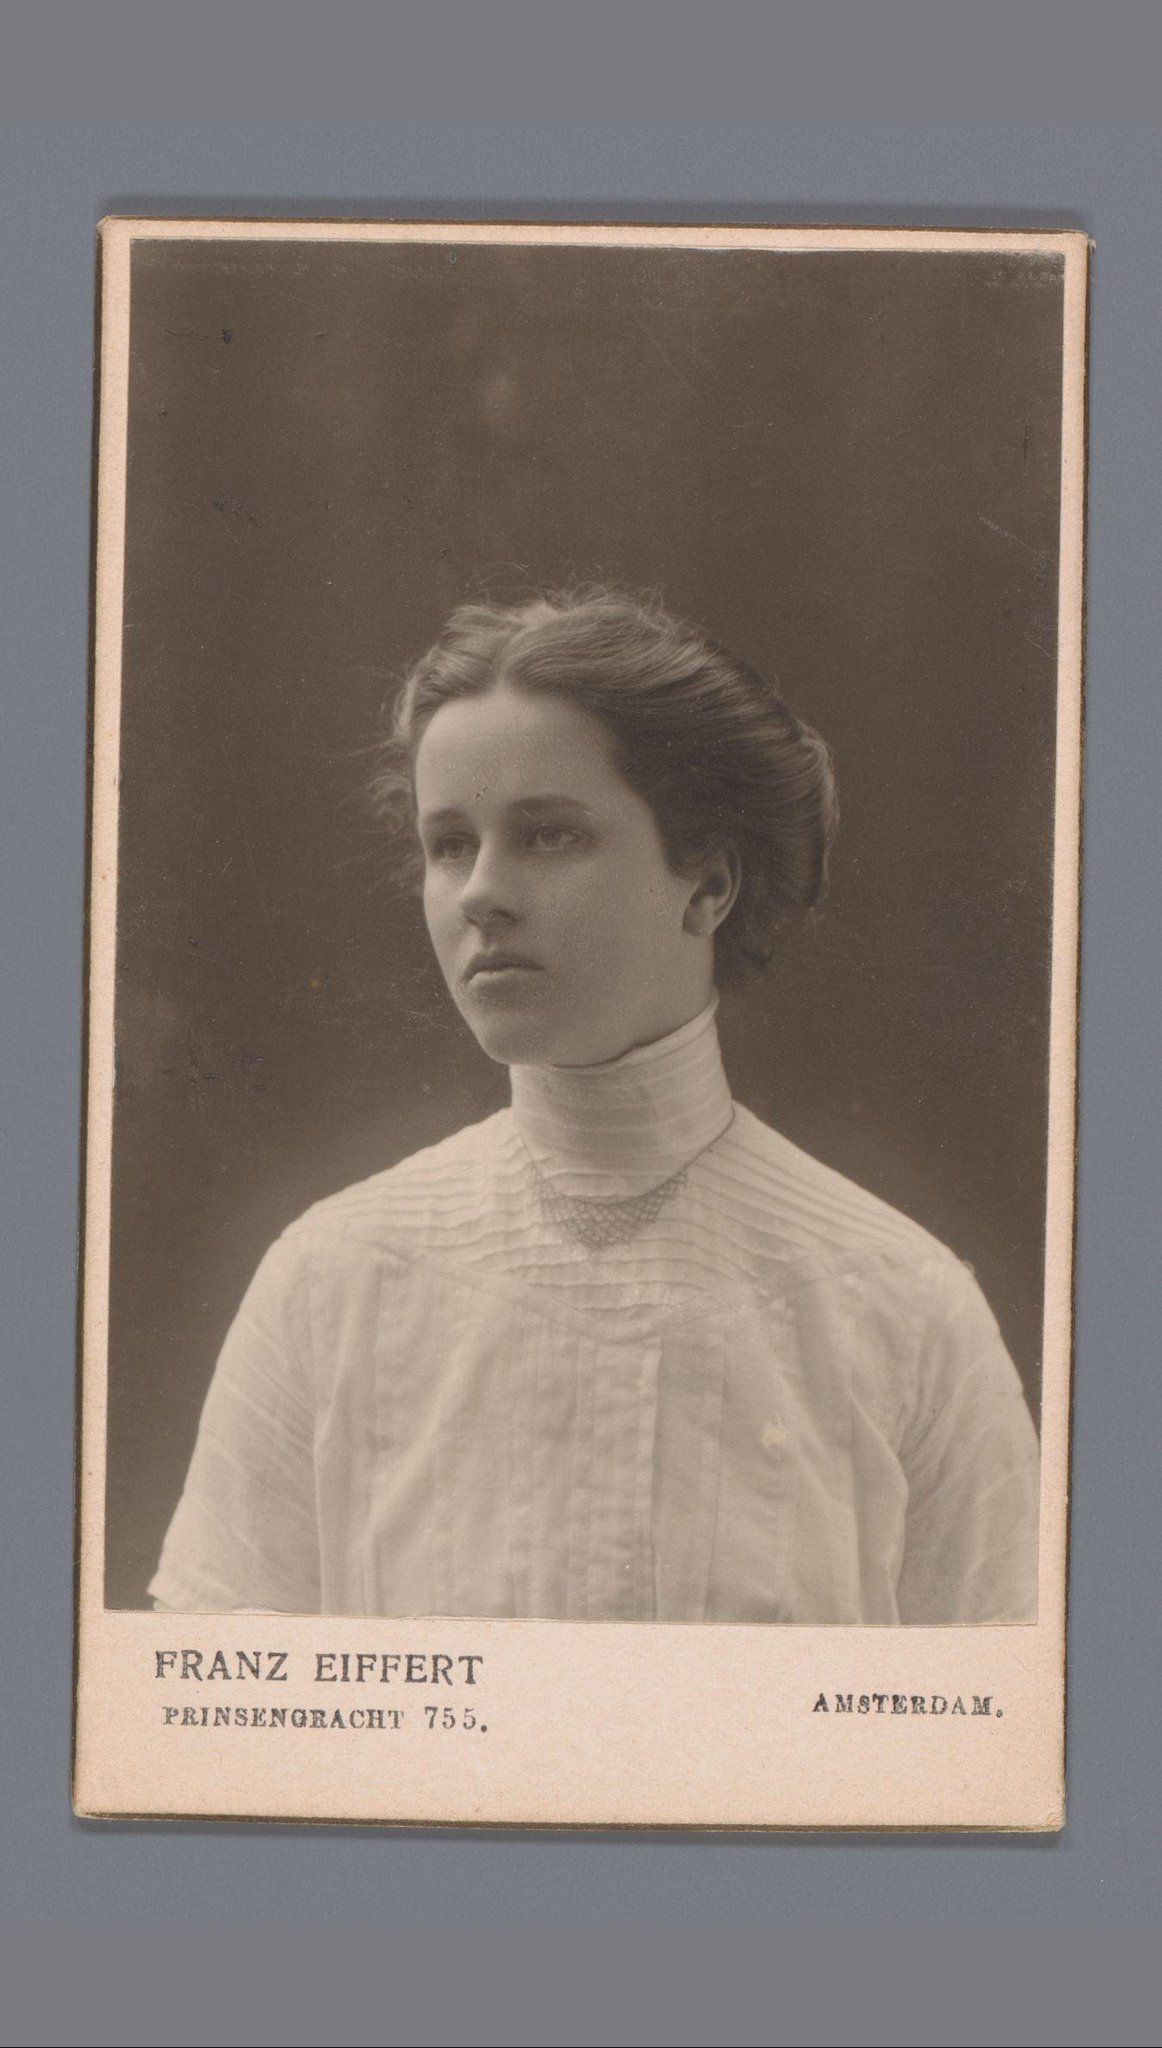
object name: carte de visite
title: Portret van Johanna Geertruida Jonker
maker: franz eiffert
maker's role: fotograaf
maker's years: 1866-1929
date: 1911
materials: cardboard, photographic support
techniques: gelatin silver print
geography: amsterdam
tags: historical persons, amsterdam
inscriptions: address: ‘Prinsengracht 755. Amsterdam’